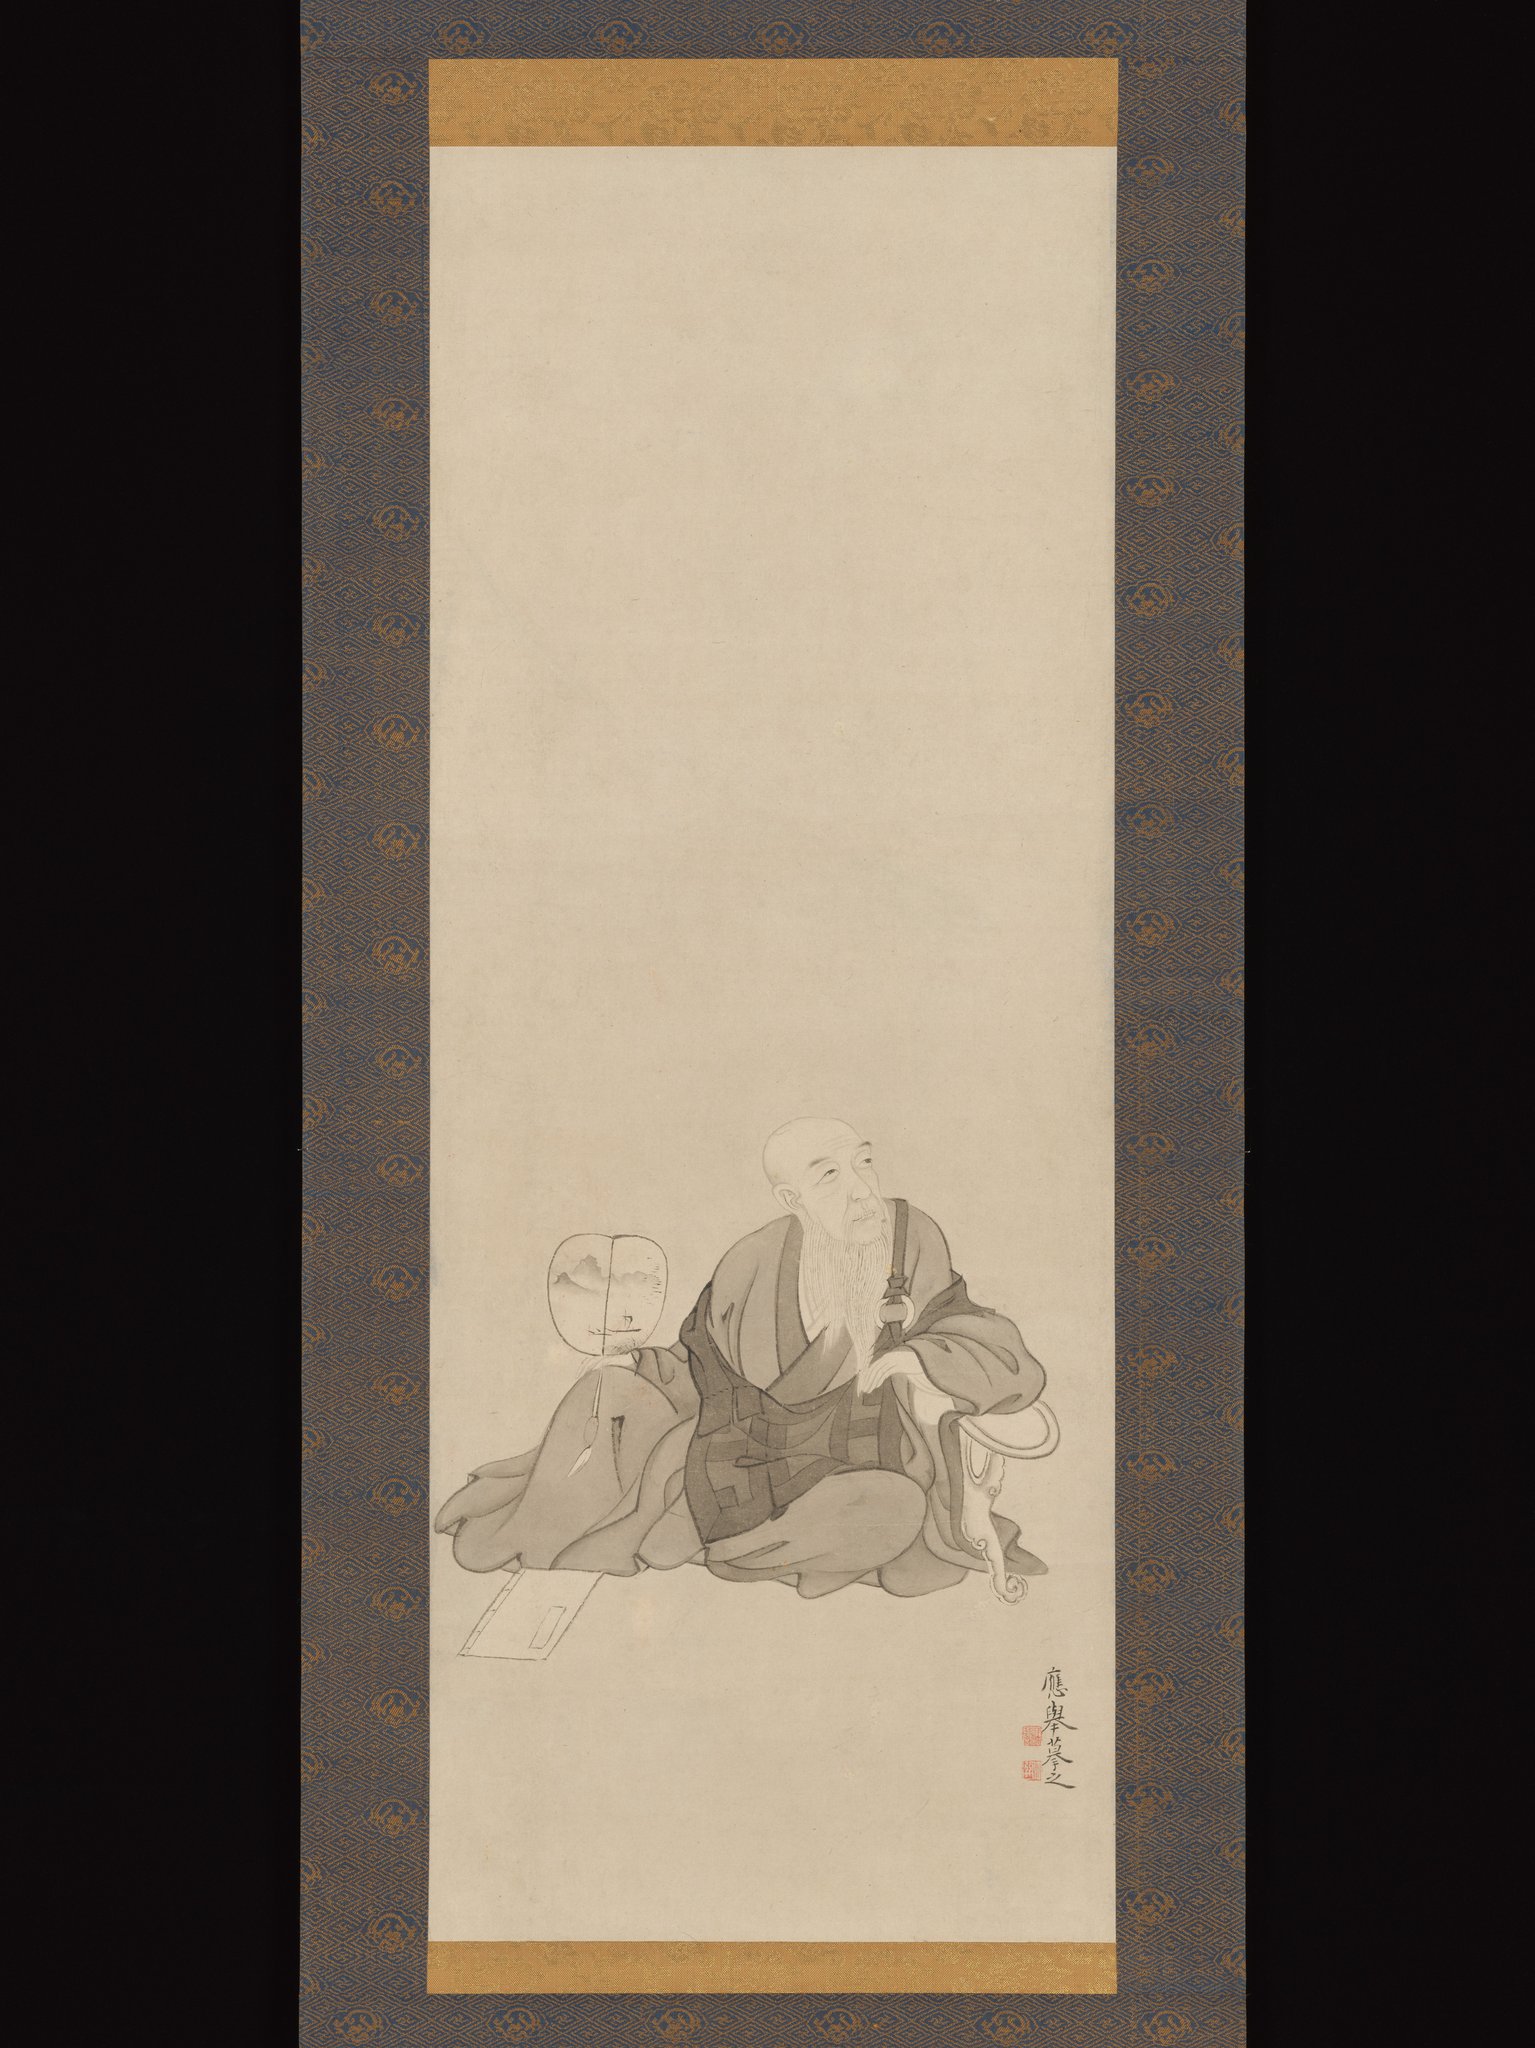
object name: hanging scroll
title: Portrait of Botanka Shōhaku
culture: japanese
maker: maruyama ōkyo 円山応挙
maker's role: artist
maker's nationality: japanese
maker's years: 1733-1795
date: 1751-1800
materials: ink, paper